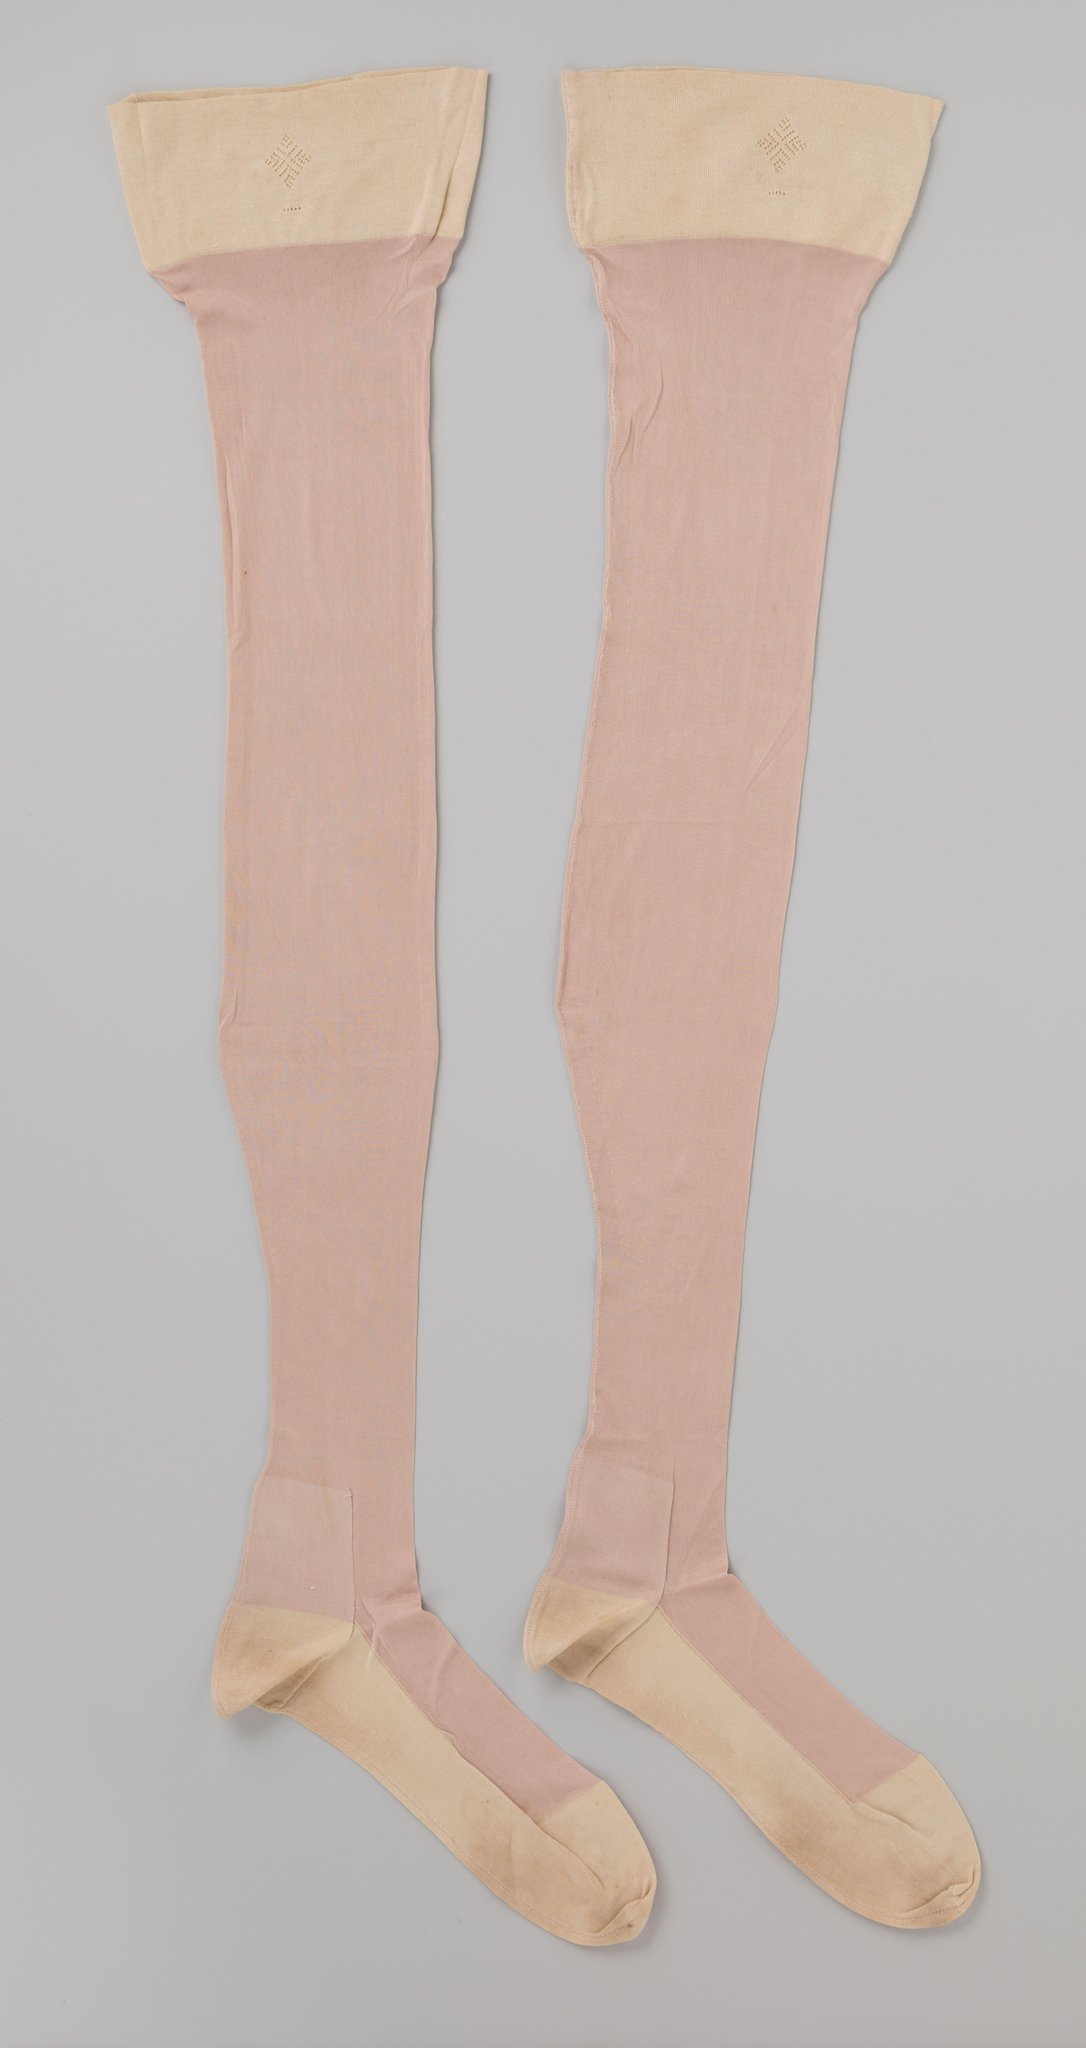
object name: stocking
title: Kous van effen roze zijde met een crèmekleurige katoenen voet en boord, waarop in ajour een ruitvormig motief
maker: elbeo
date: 1940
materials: cotton, silk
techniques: knitting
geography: germany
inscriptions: initials: ‘'LBO'’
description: Kous van effen roze zijde met een crèmekleurige katoenen voet en boord. Op de brede boord in ajour een ruitvormig motief, naar binnen geslagen, met binnenin 'LBO'. Naad middenachter.